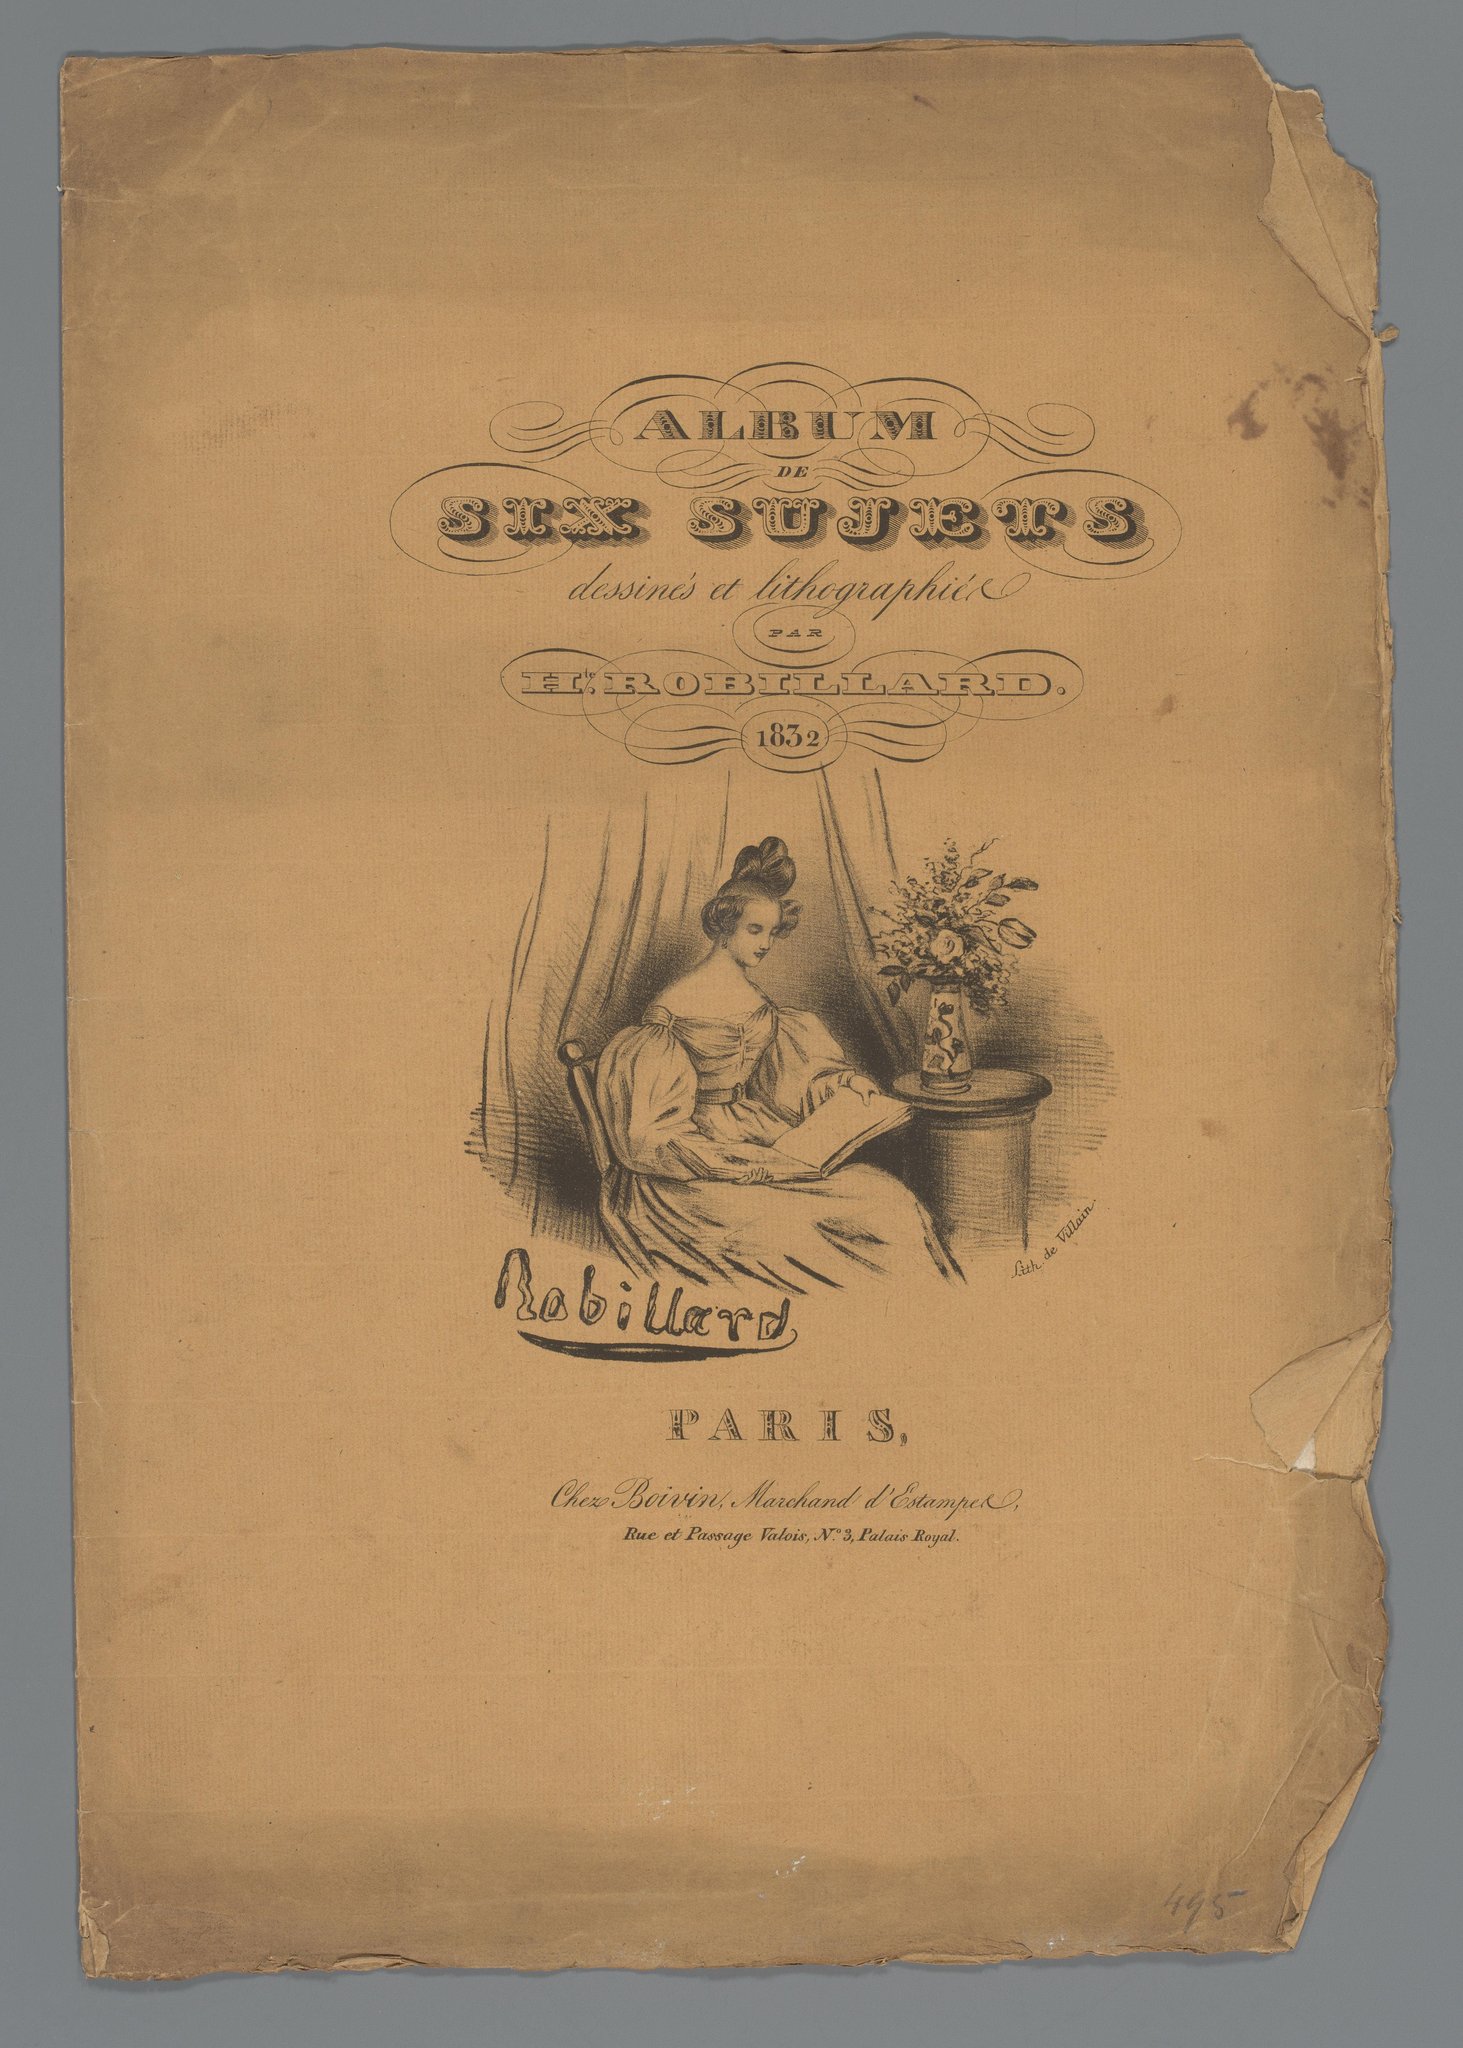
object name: print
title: Zes vrouwenonderwerpen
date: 1832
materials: paper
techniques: letterpress printing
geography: paris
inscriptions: collector's mark: Lugt 2228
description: Voluit: Album de six sujets dessinés et lithographié par Hte. Robillard.